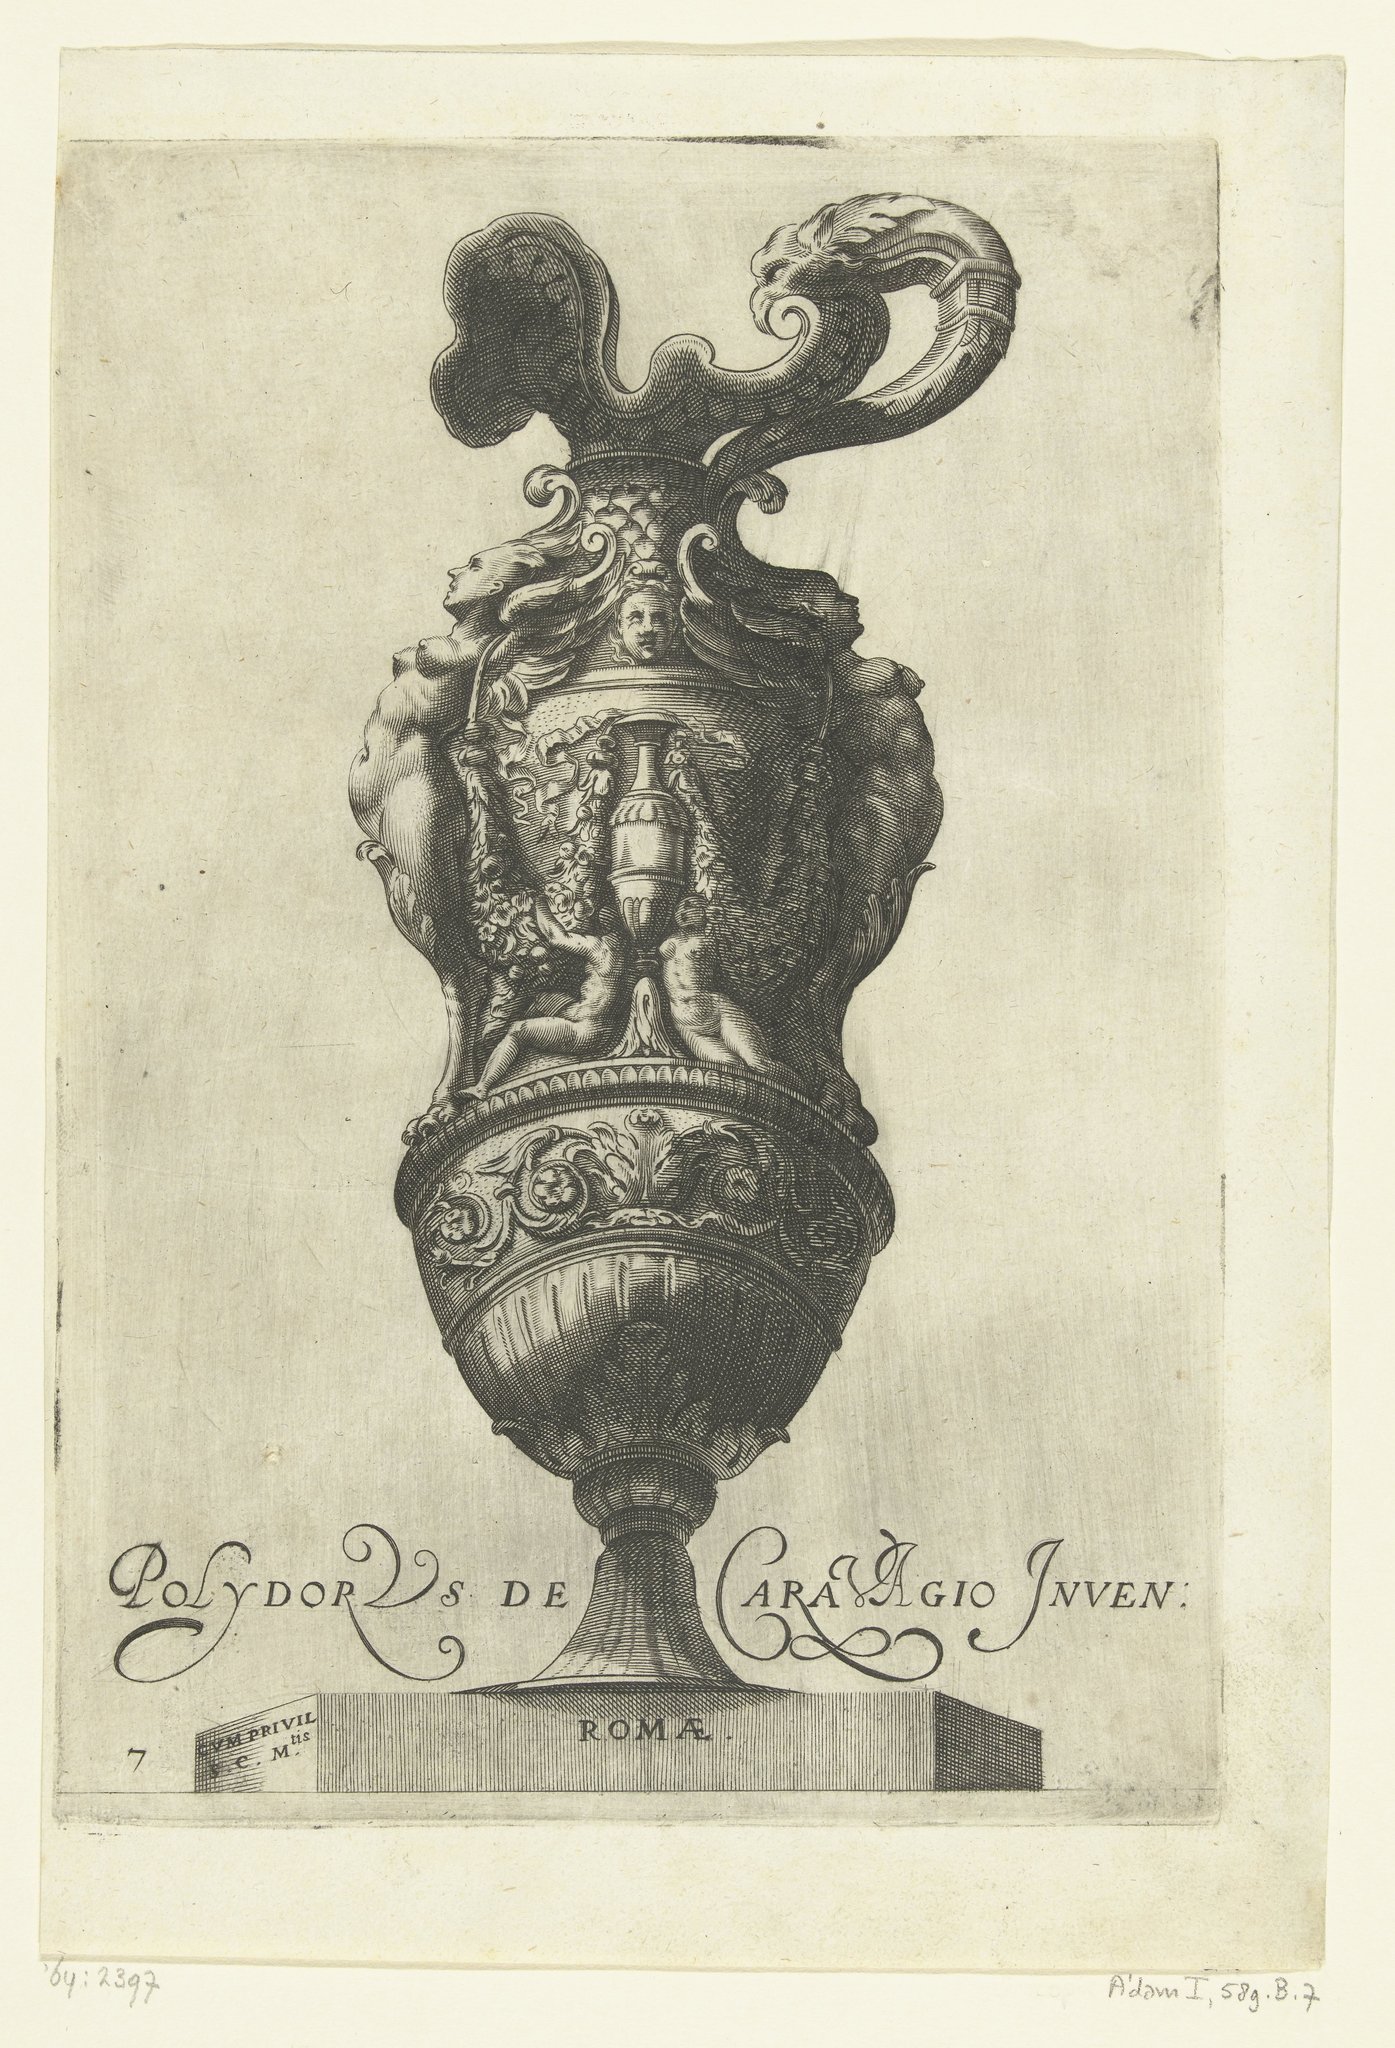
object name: ornament print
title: Vasa a Polydor (...)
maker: aegidius sadeler (ii)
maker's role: draughtsman, print maker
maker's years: 1568-1629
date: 1580-1605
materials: paper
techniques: engraving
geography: prague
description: De buik van de kan is gedecoreerd met twee gevleugelde vrouwelijke saters. Tegenzijdige kopie naar RP-P-1964-2389.